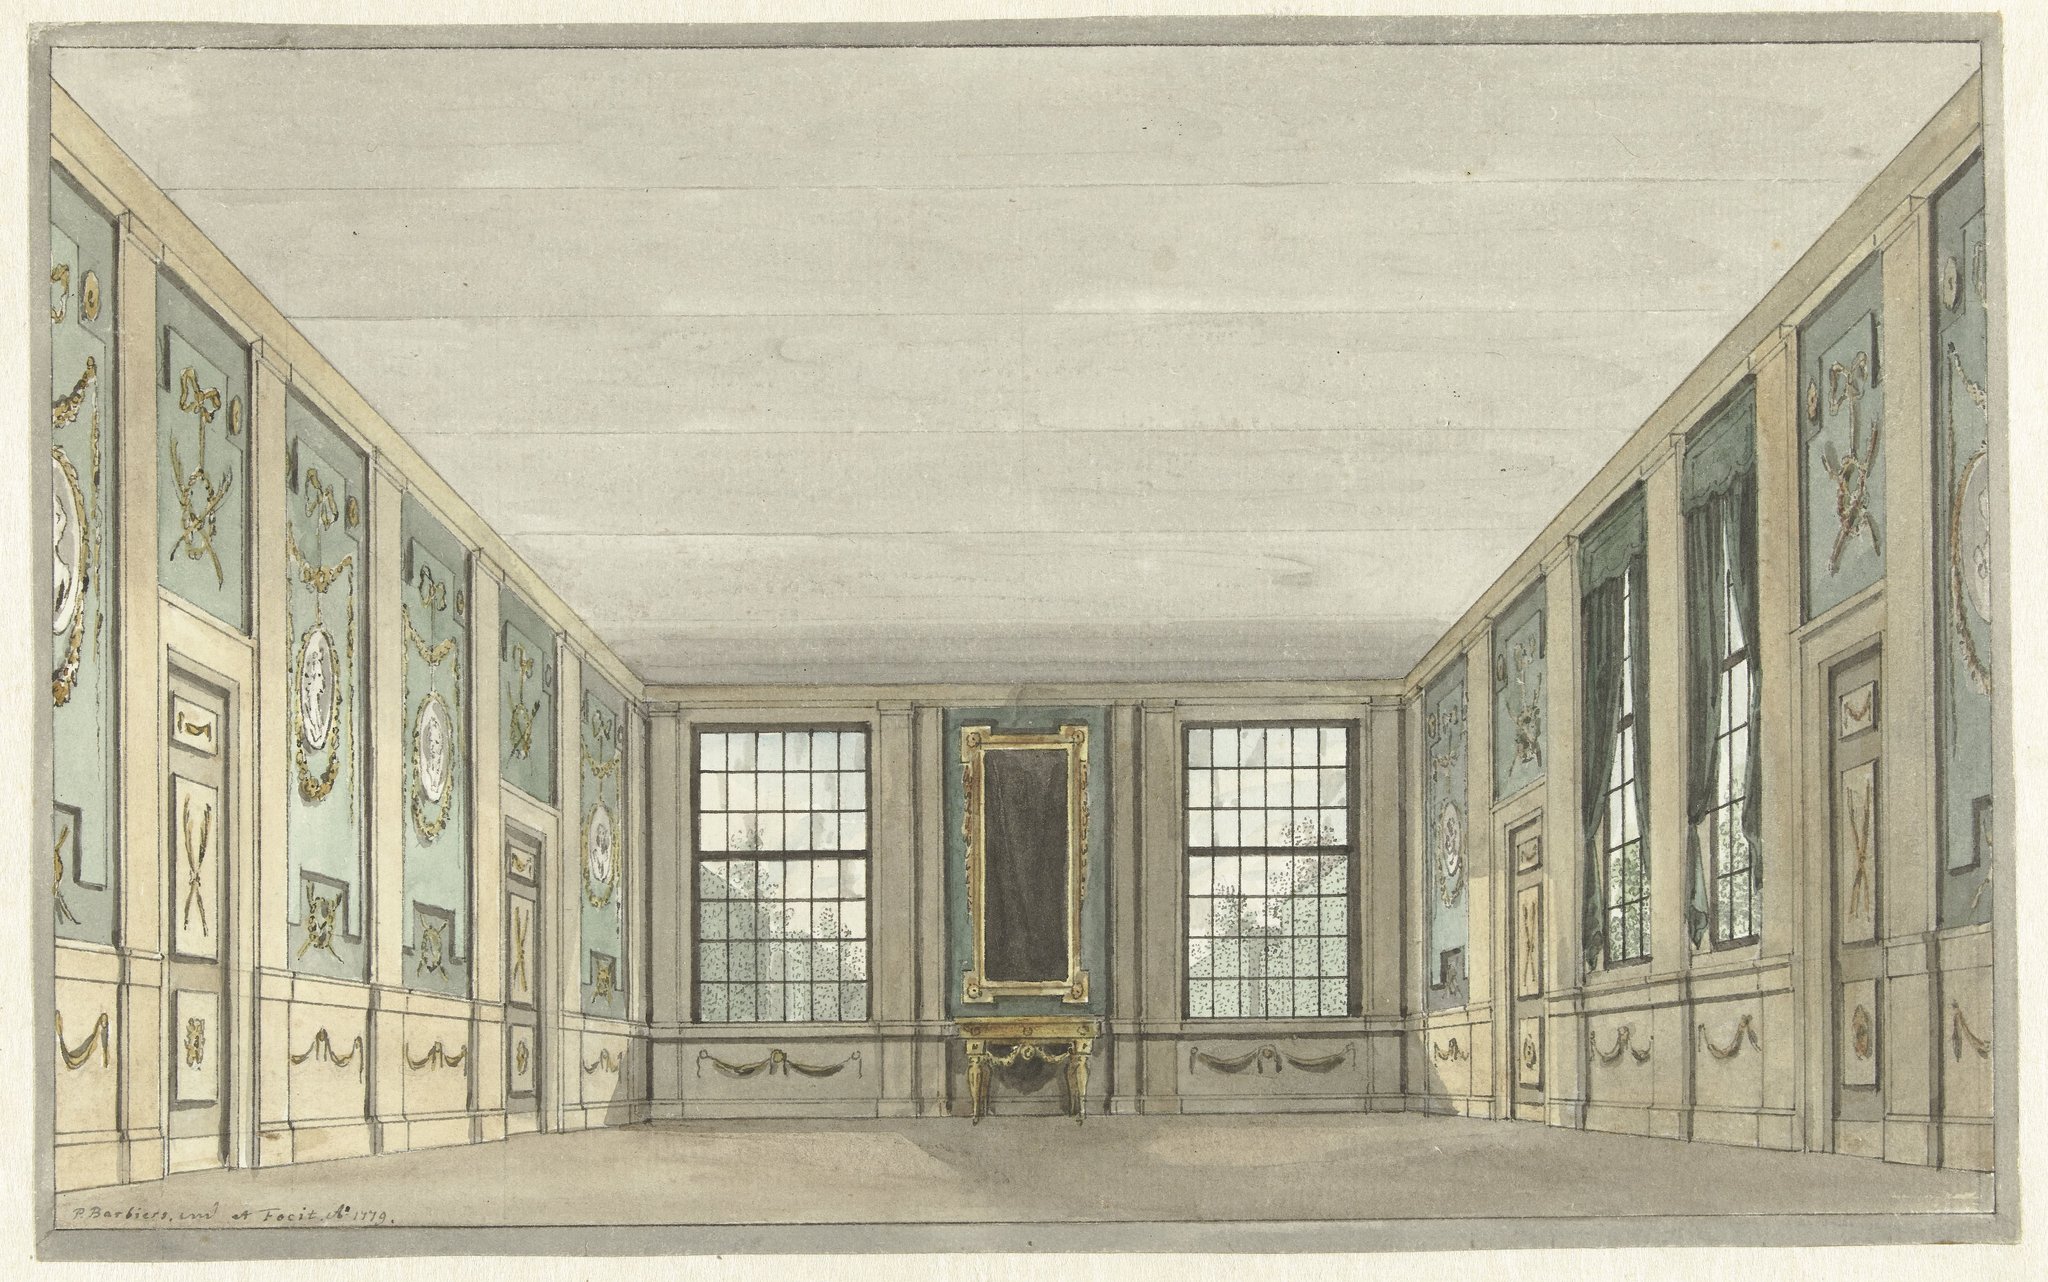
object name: watercolor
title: Ontwerp voor een toneeldecor van een interieur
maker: pieter barbiers (i)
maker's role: print maker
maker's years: 1717-1780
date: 1779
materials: graphite, ink, paper, watercolor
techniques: brush, pen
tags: stage design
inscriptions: date: ‘1779’